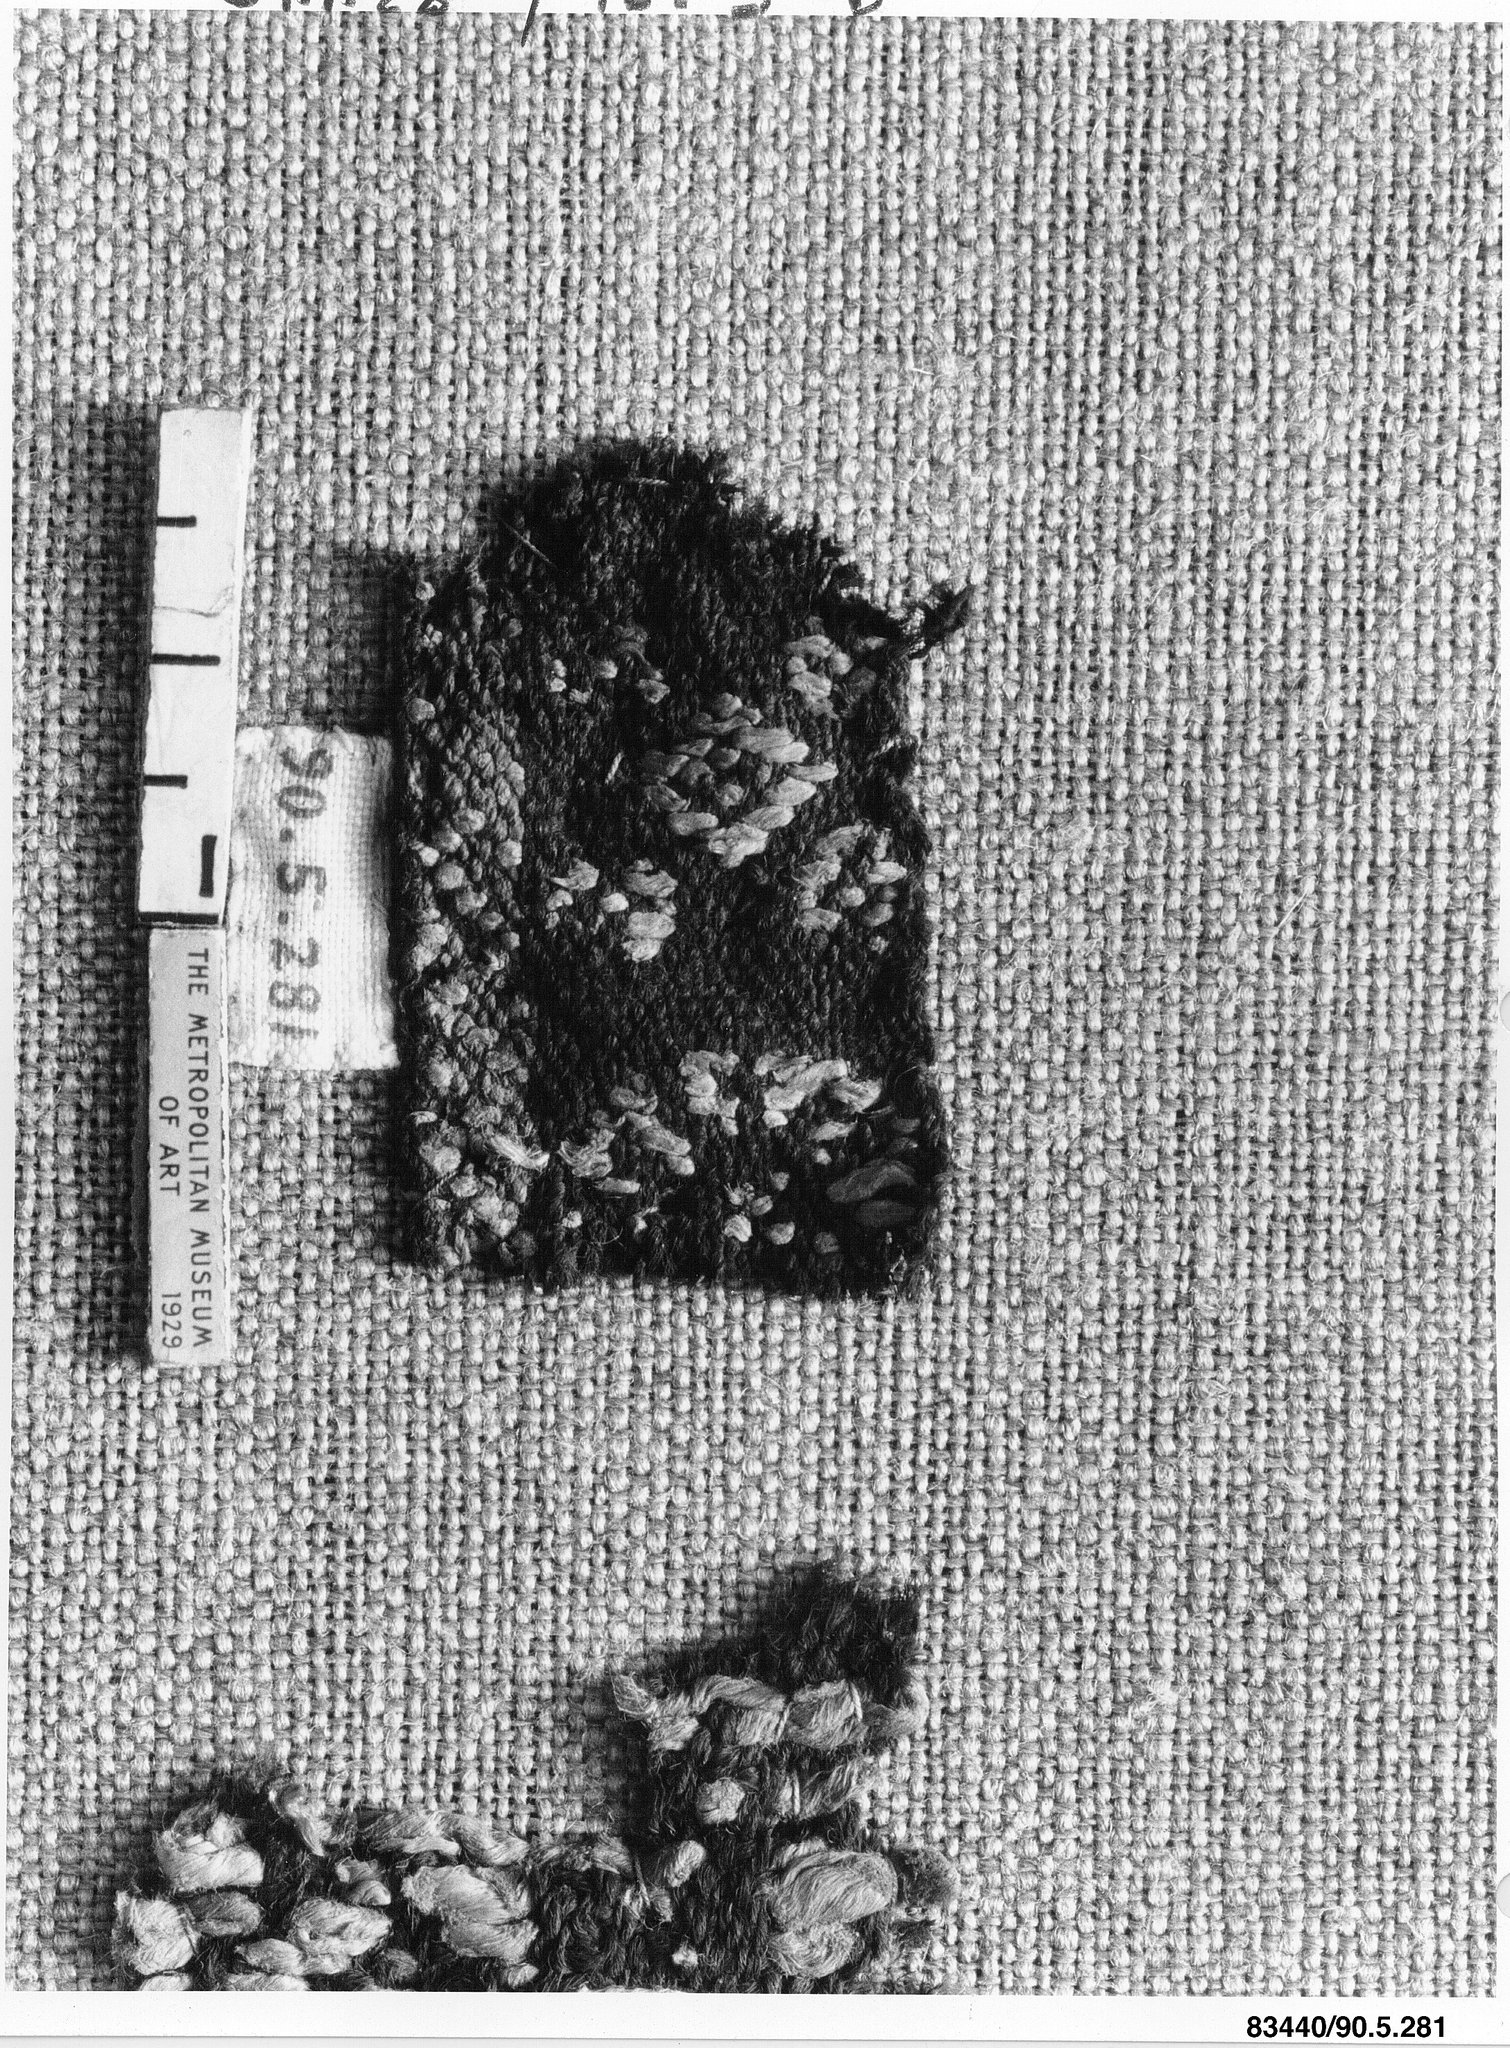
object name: textile fragment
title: Fragment of a Band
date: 401-600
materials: linen, wool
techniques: weave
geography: egypt